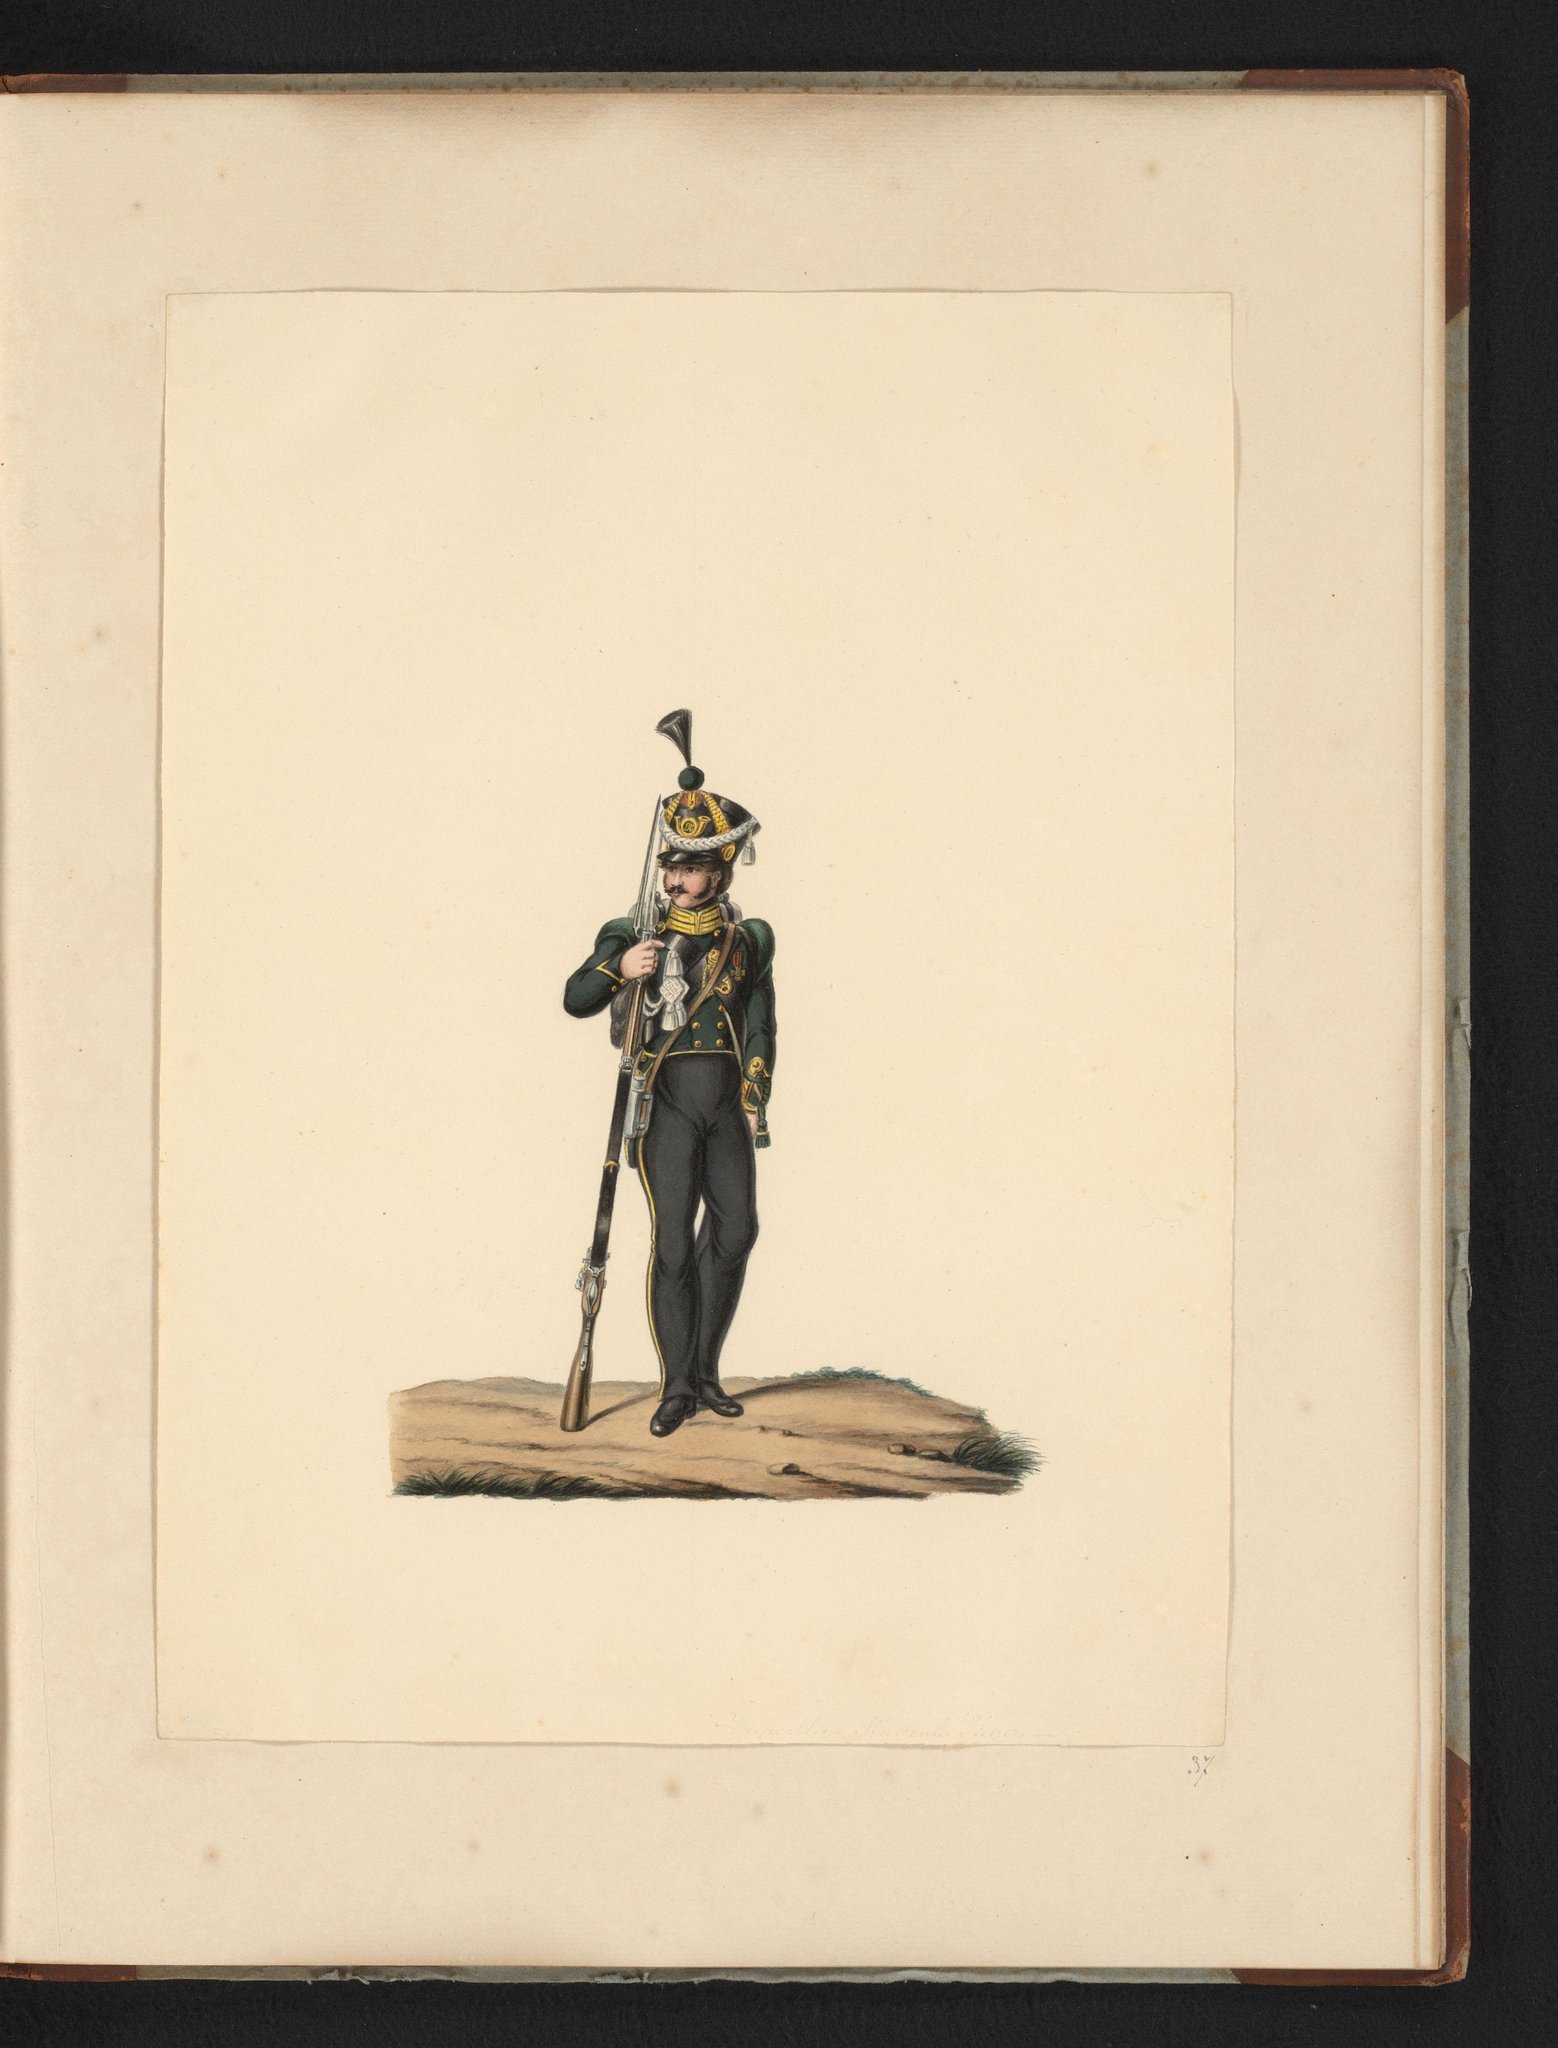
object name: costume print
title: Vrijwillige jager van de Hogescholen van Leiden en Utrecht, 1830-1831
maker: Anonymous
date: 1831-1832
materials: paper, pencil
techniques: brush, lacquer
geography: netherlands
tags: professional clothes, (military) uniforms, netherlands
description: Een jager van de Compagnie Vrijwillige Flankeurs van de Hogescholen te Leiden en Utrecht, te voet. Onderdeel van het album met 39 ingeplakte tekeningen van militairen van de Koninklijke Nederlandsche Armee uit 1830-1831.